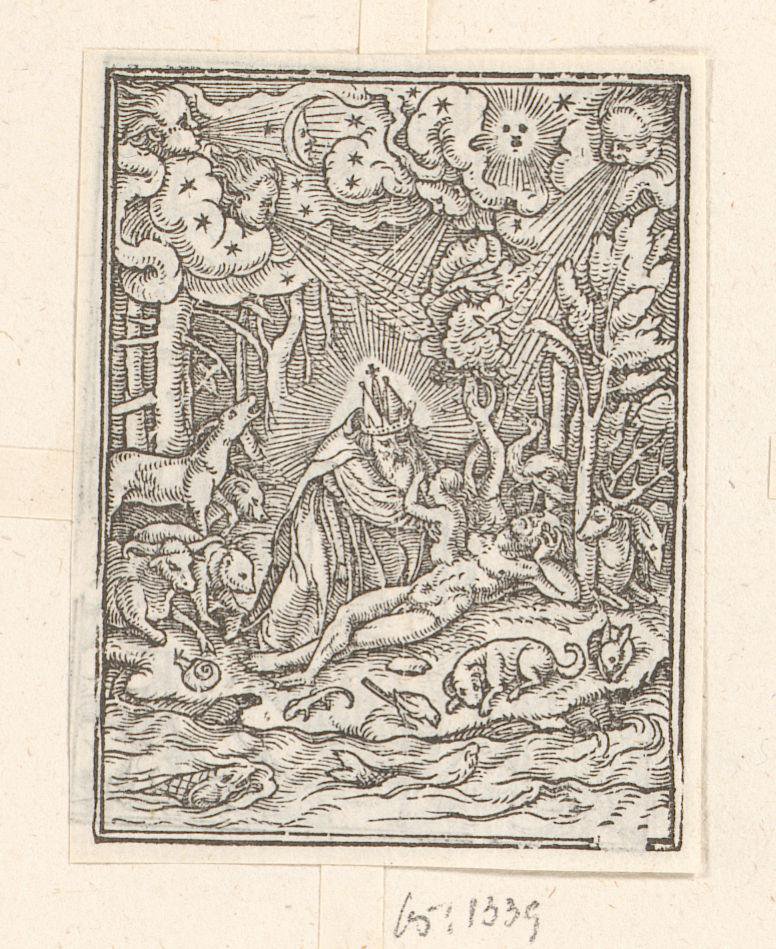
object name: book illustration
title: Dodendans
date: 1524-1526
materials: paper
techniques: woodcut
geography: switzerland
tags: eve is fashioned from adam's rib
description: Boekillustratie voor: Les simulacres & historiees faces de la mort, avtant elegamment pourtraictes, que artificiellement imaginées ... Lyon: M. en G. Trechsel, voor Jean en Francois Frellon, 1538.